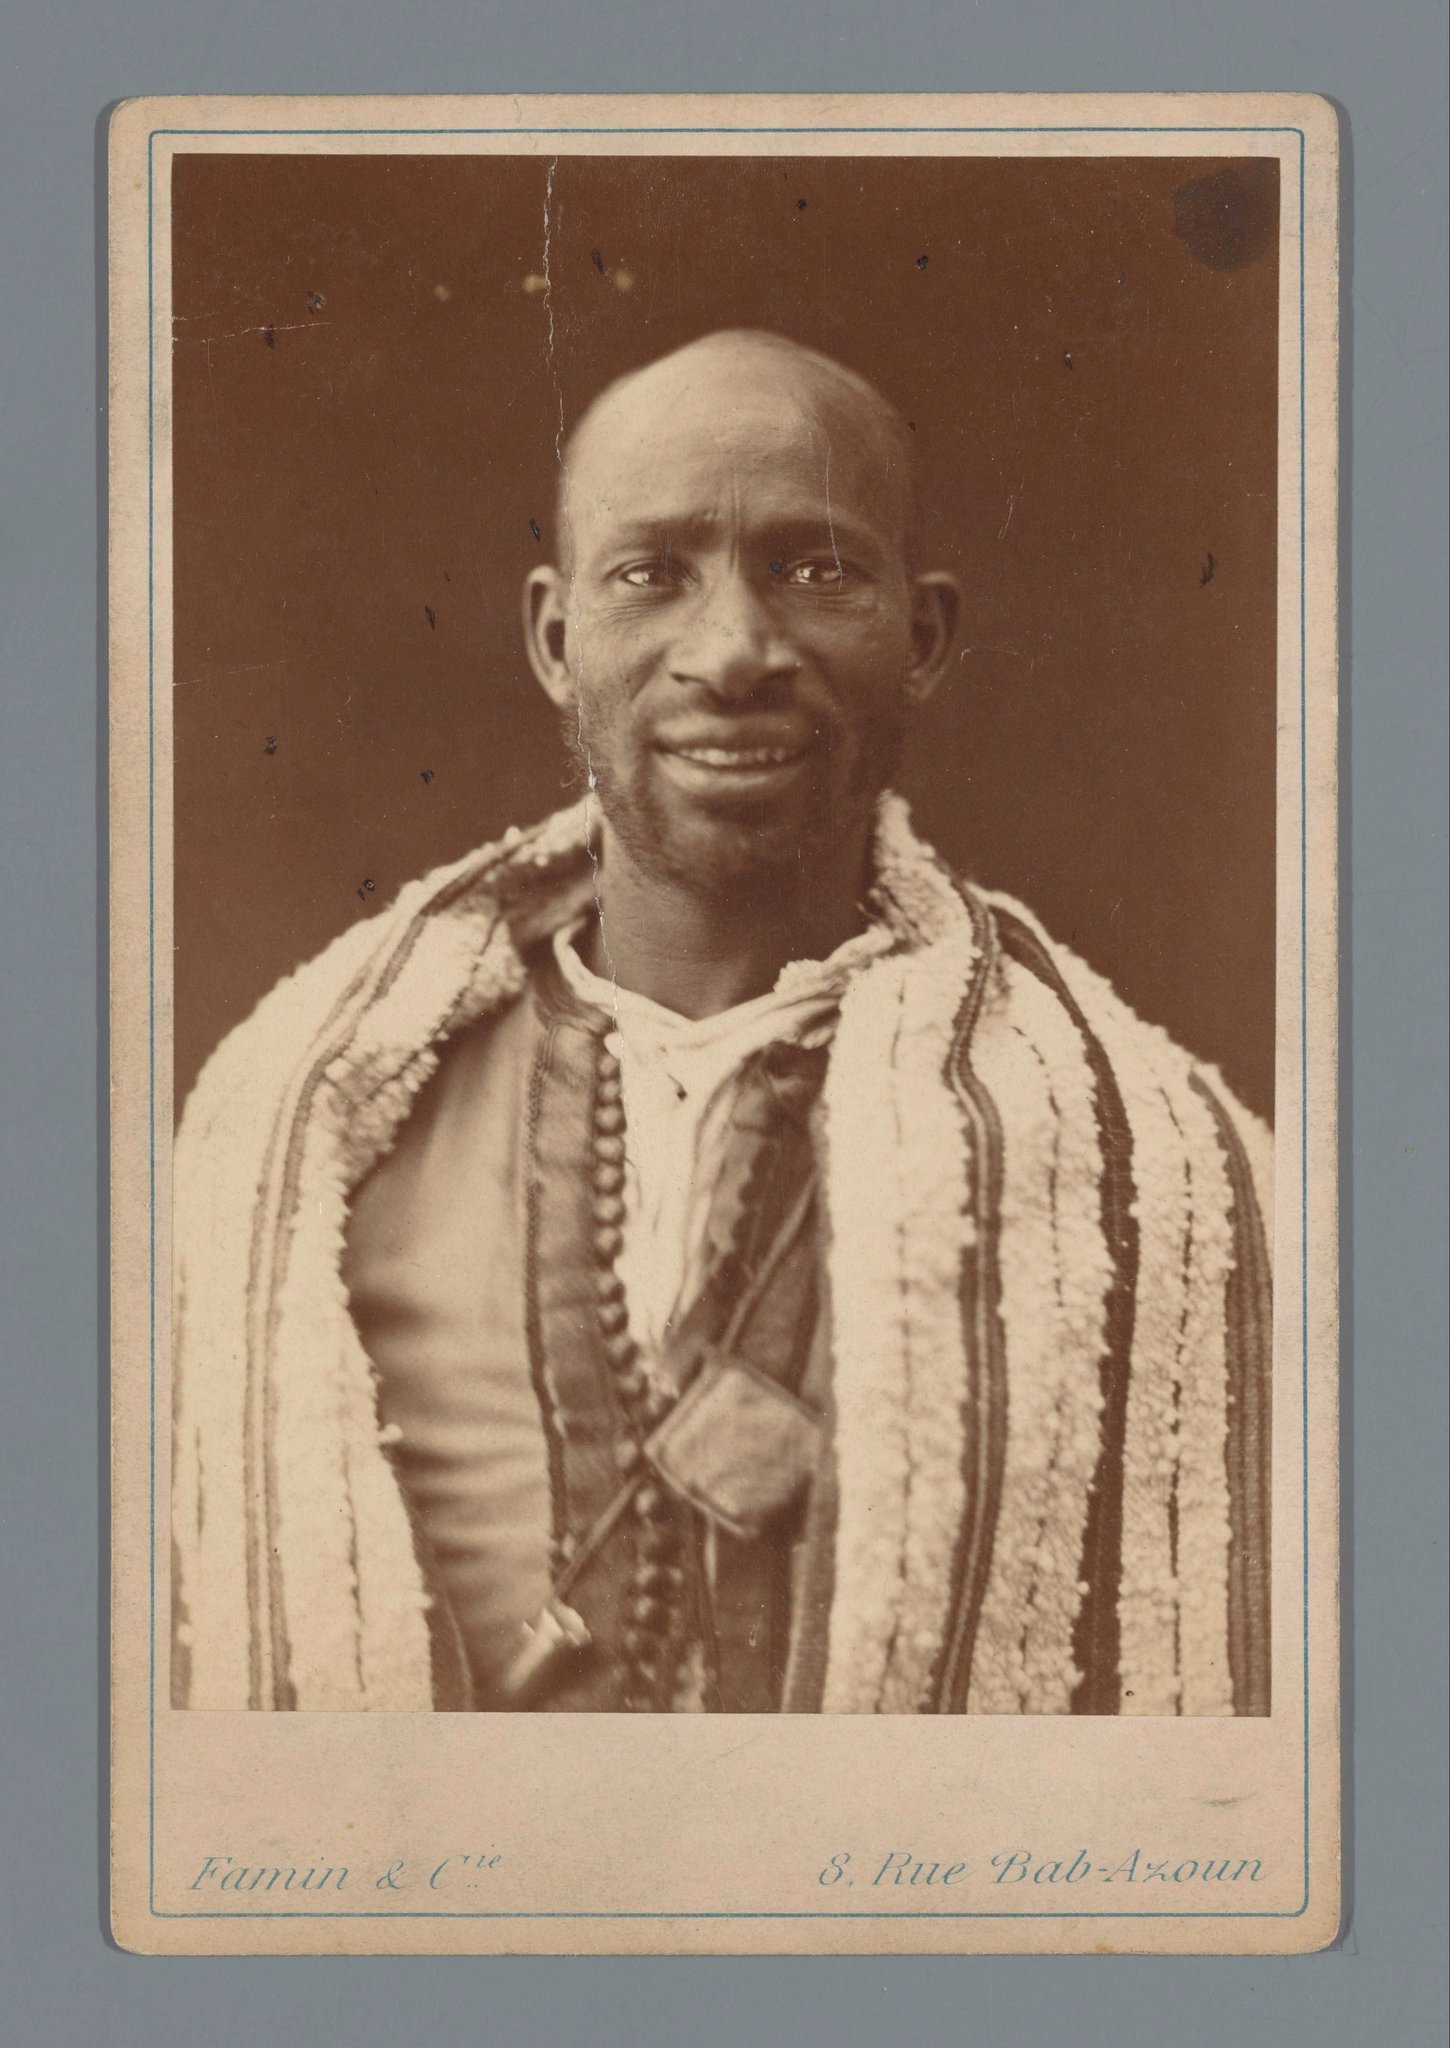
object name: cabinet photograph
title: Portret van een onbekende man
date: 1863-1889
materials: cardboard, photographic support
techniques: albumen print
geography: algeria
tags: anonymous historical person portrayed, clothes, costume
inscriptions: inscription: ‘Alger/ 8, Rue Bab-Azoun, 8’, inscription: ‘8, Rue Bab-Azoun’, inscription: ‘Negro (Salem)’